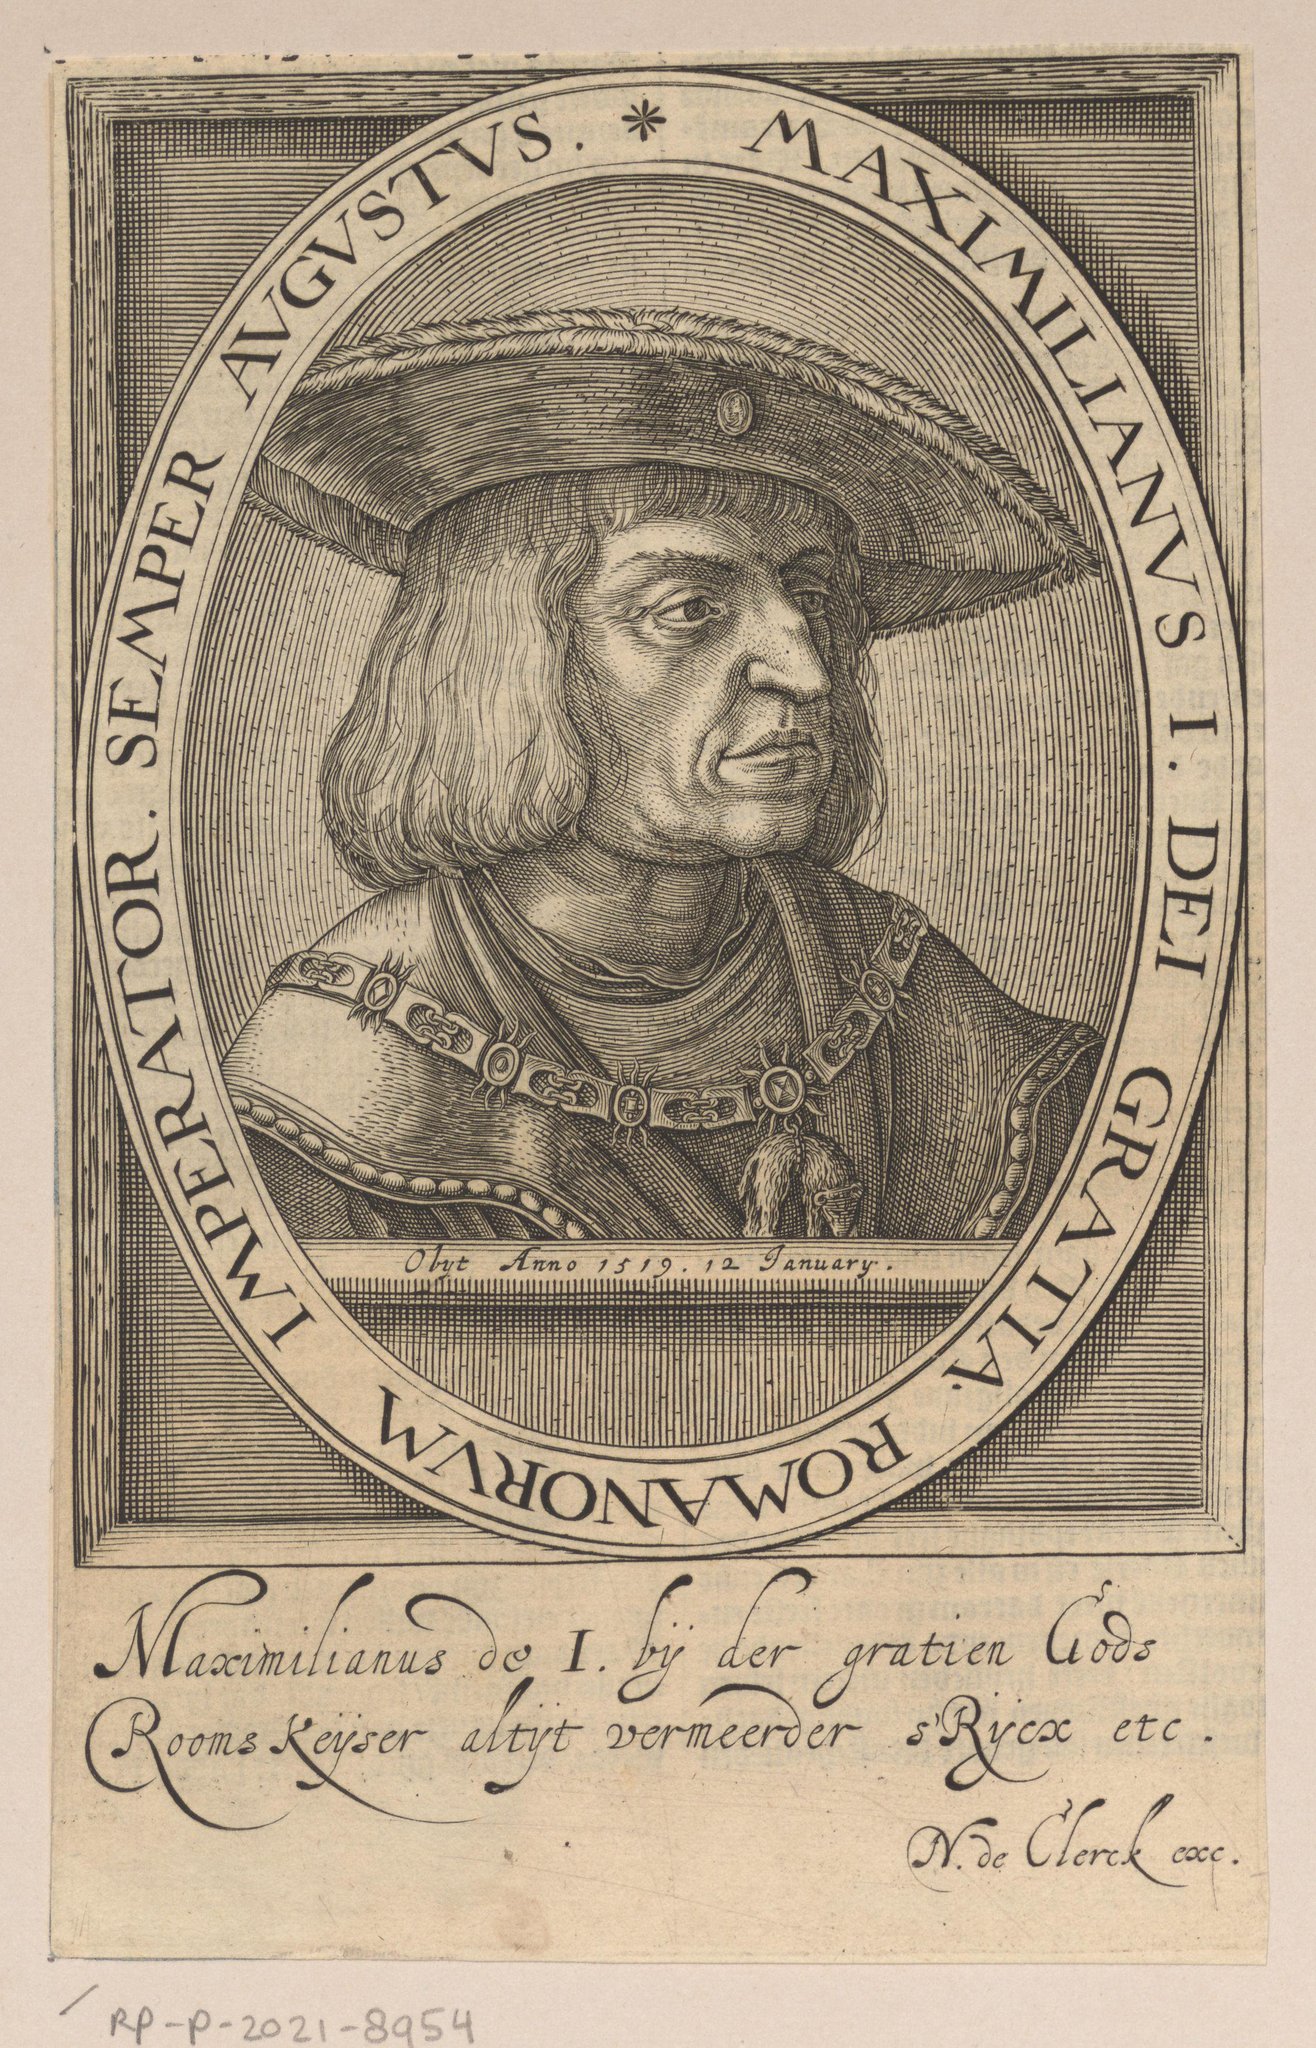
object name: book illustration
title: Portret van keizer Maximiliaan I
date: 1610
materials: paper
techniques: engraving, letterpress printing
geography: delft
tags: maximilian i (holy roman emperor), historical persons, emperor, knighthood order of the golden fleece - insignia of a knighthood order, e.g.: badge, chain (with name of order)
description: Prent uit: Ulloa, Alfonso de. Historie, ende het leven van den aldermachtichsten ende victorieusten keyser Caerle de vijfde (...). Delft: Adriaen Gerritsz., 1610.